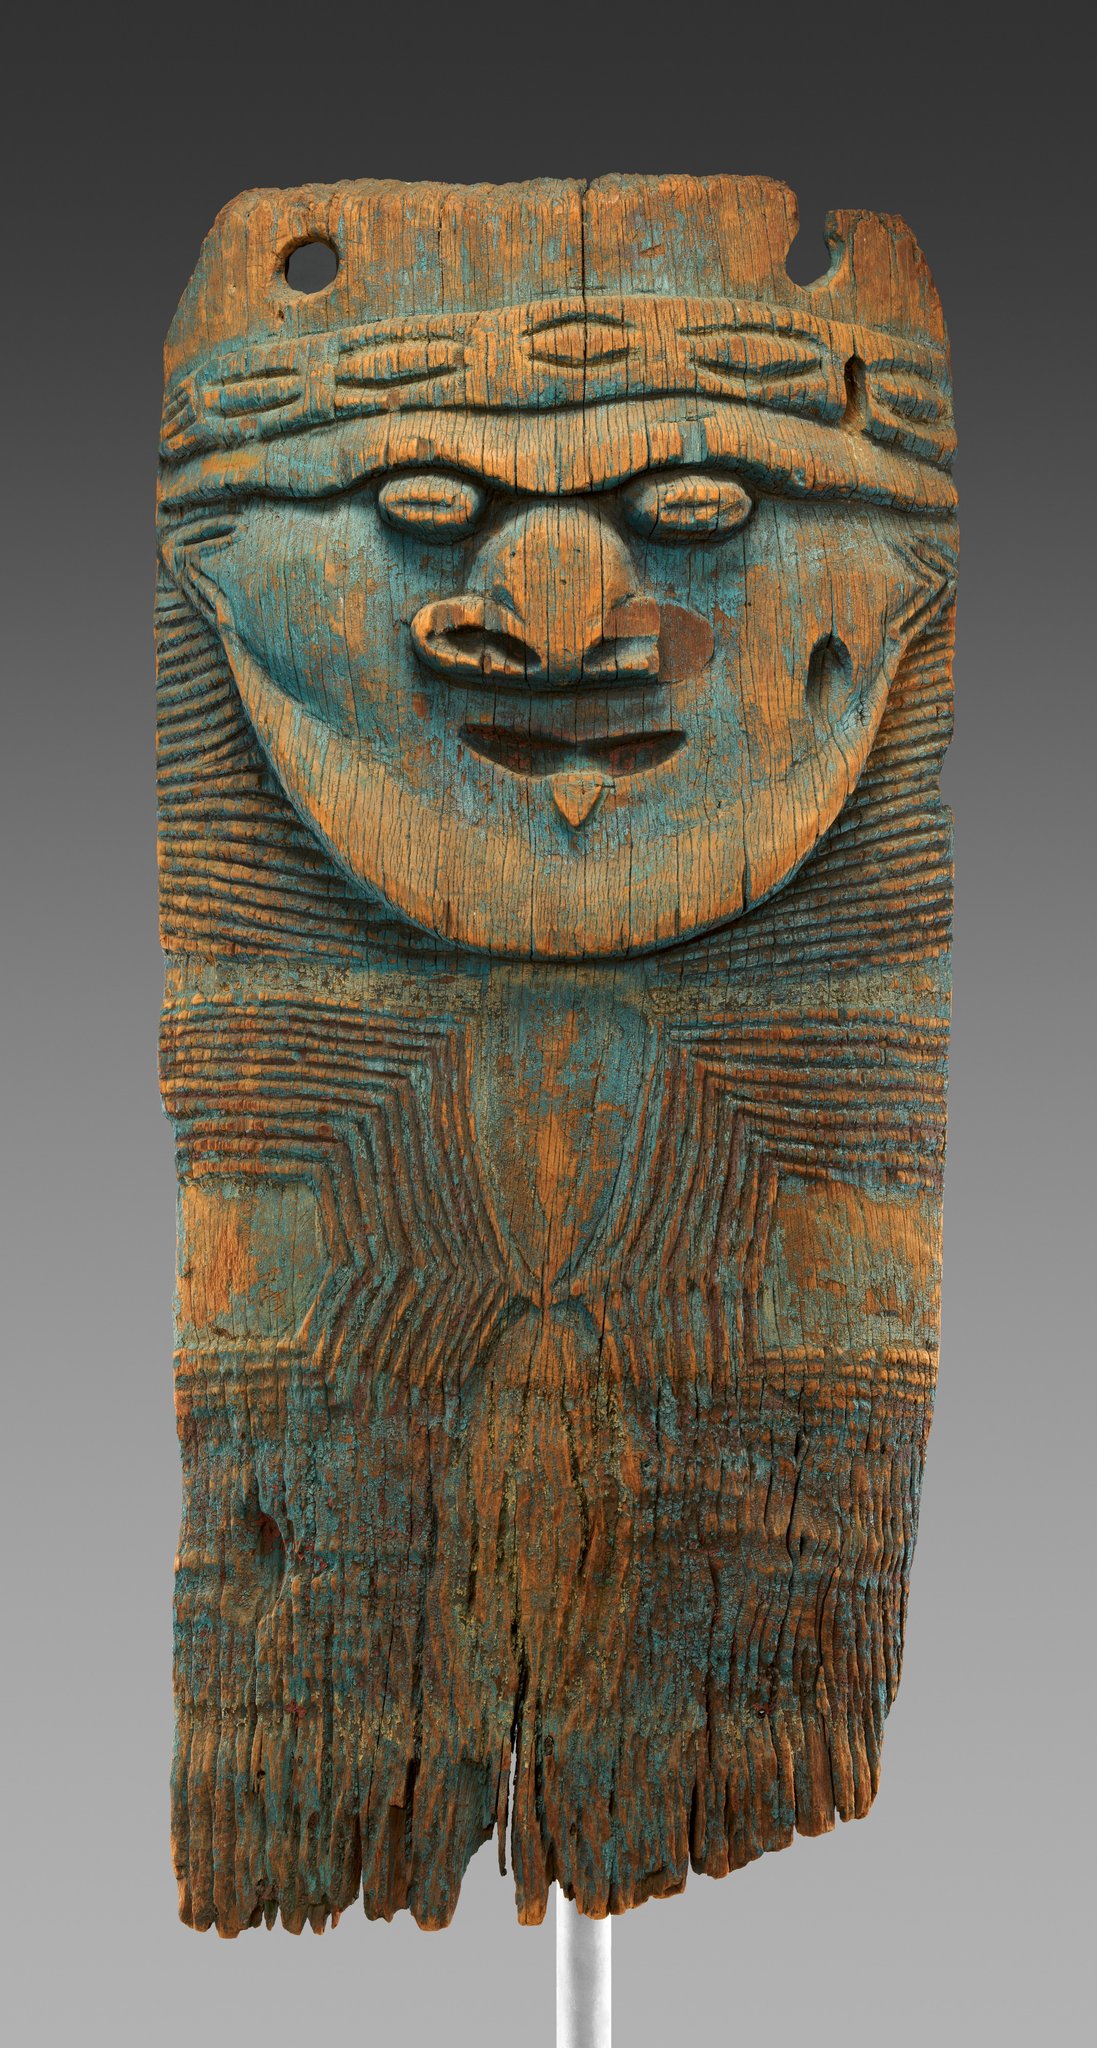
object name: door board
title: Door board (jovo)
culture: kanak people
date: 1801-1900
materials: pigment, wood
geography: new caledonia